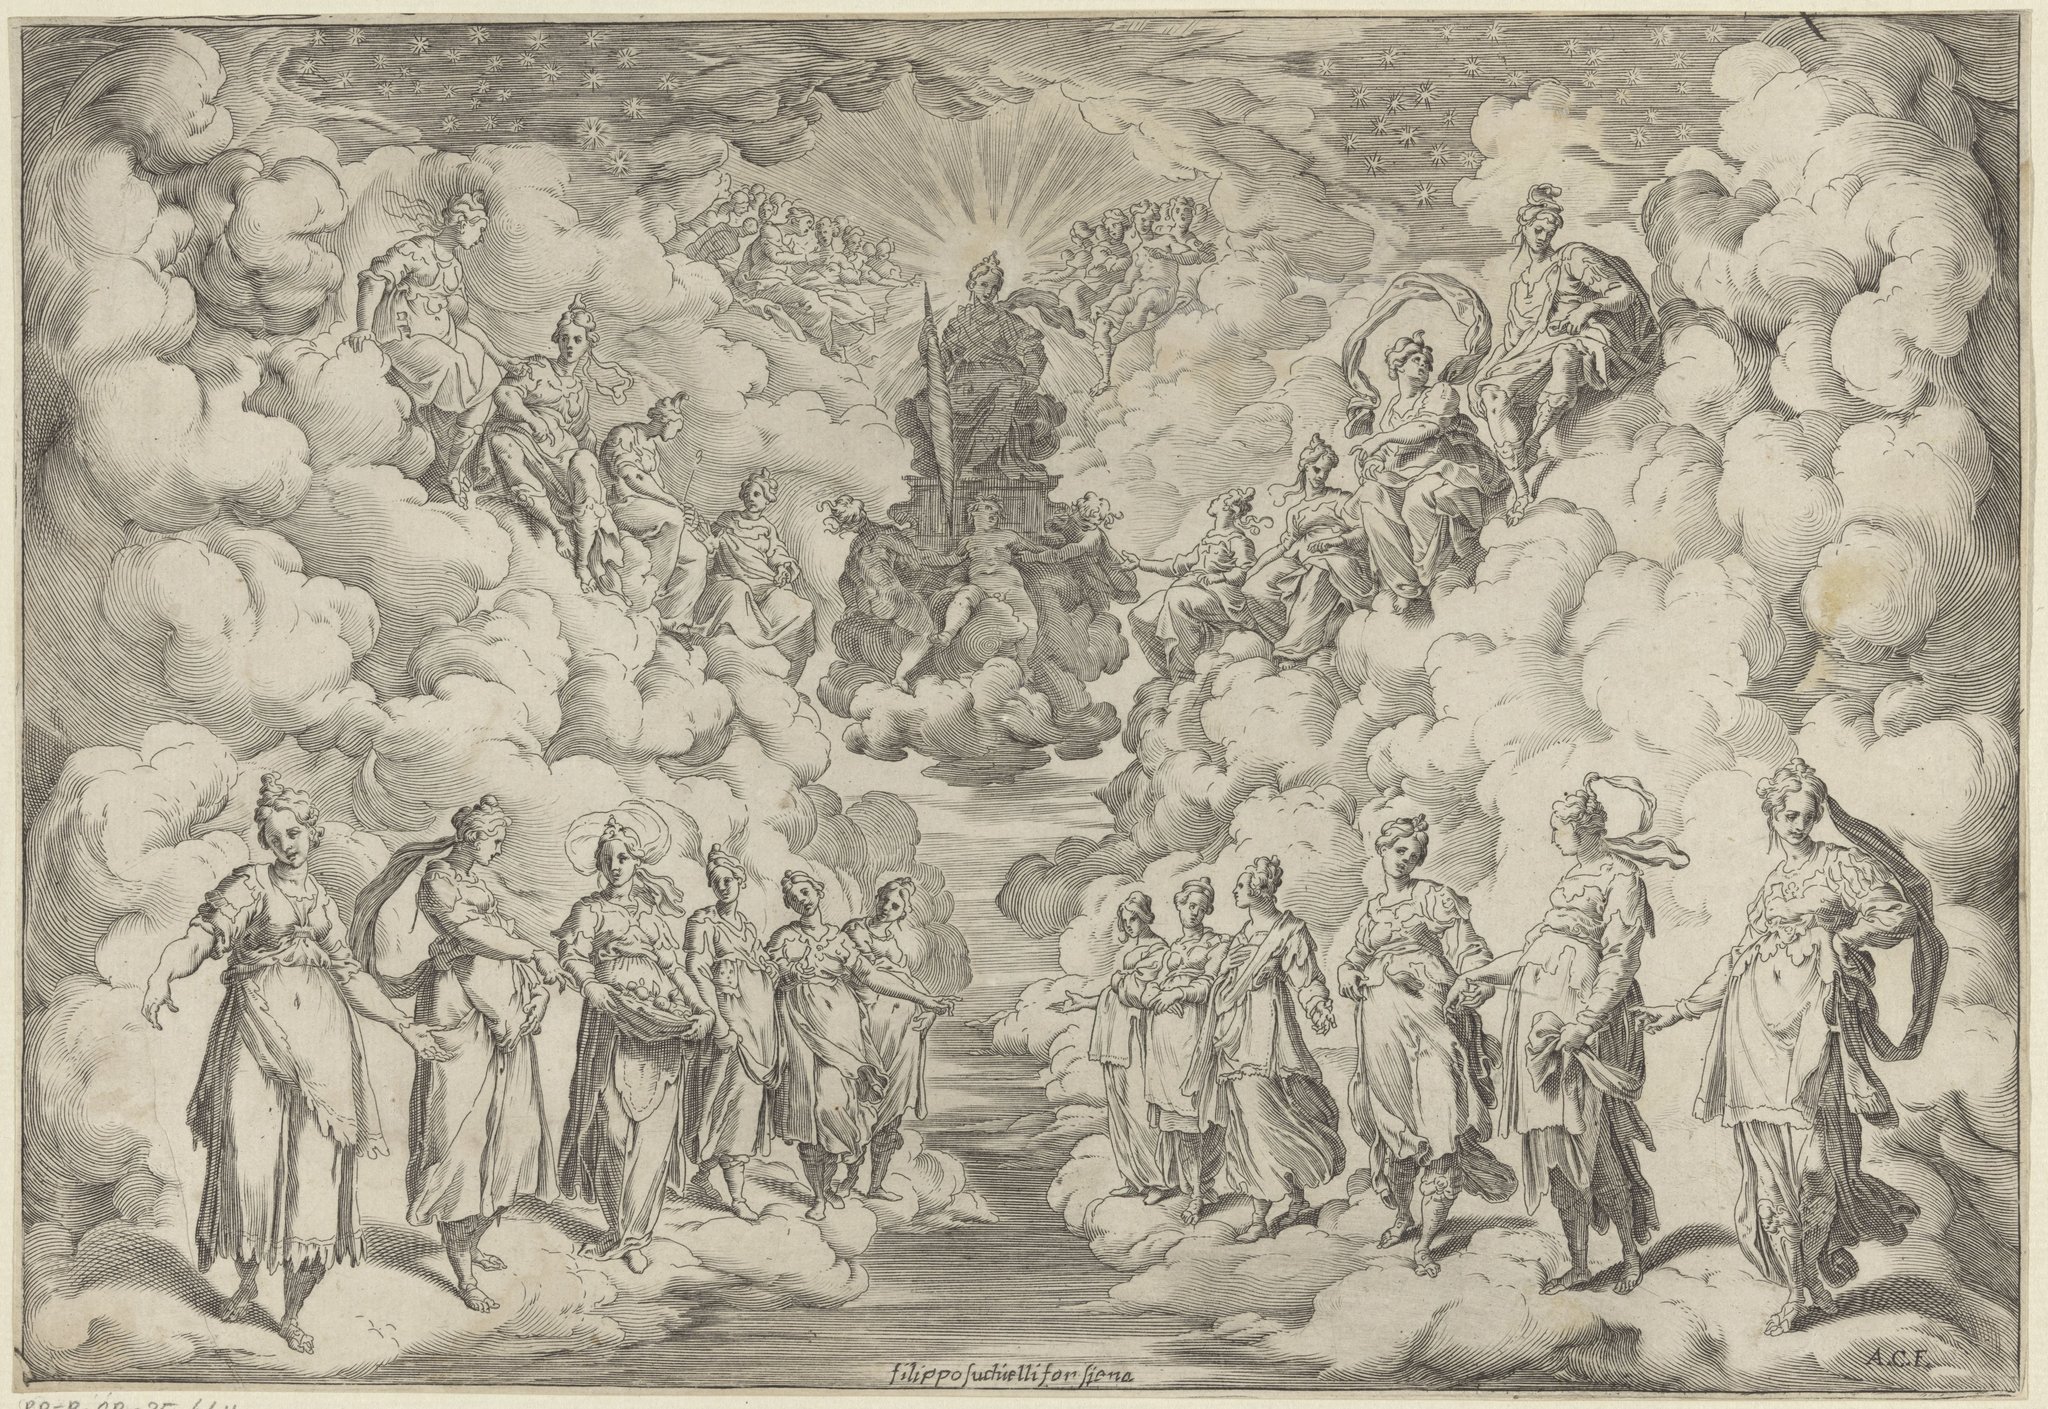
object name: print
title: Harmonie van de sferen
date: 1589-1592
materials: paper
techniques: engraving, etching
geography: florence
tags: ferdinando i de' medici, spheres ~ heavens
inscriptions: collector's mark: Lugt 240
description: Weergave van het eerste intermezzo tijdens de uitvoering van het toneelstuk 'La Pellegrina' van Girolamo Bargagli: De sferen zitten en staan in rijen op wolken. Voor de zes intermezzi van Giovanni de'Bardi werden de machines en kostuums ontworpen door Bernardo Buontalenti. Deze uitvoering was ter gelegenheid van het huwelijk van Ferdinando I de'Medici en Christina van Lotharingen in 1589.